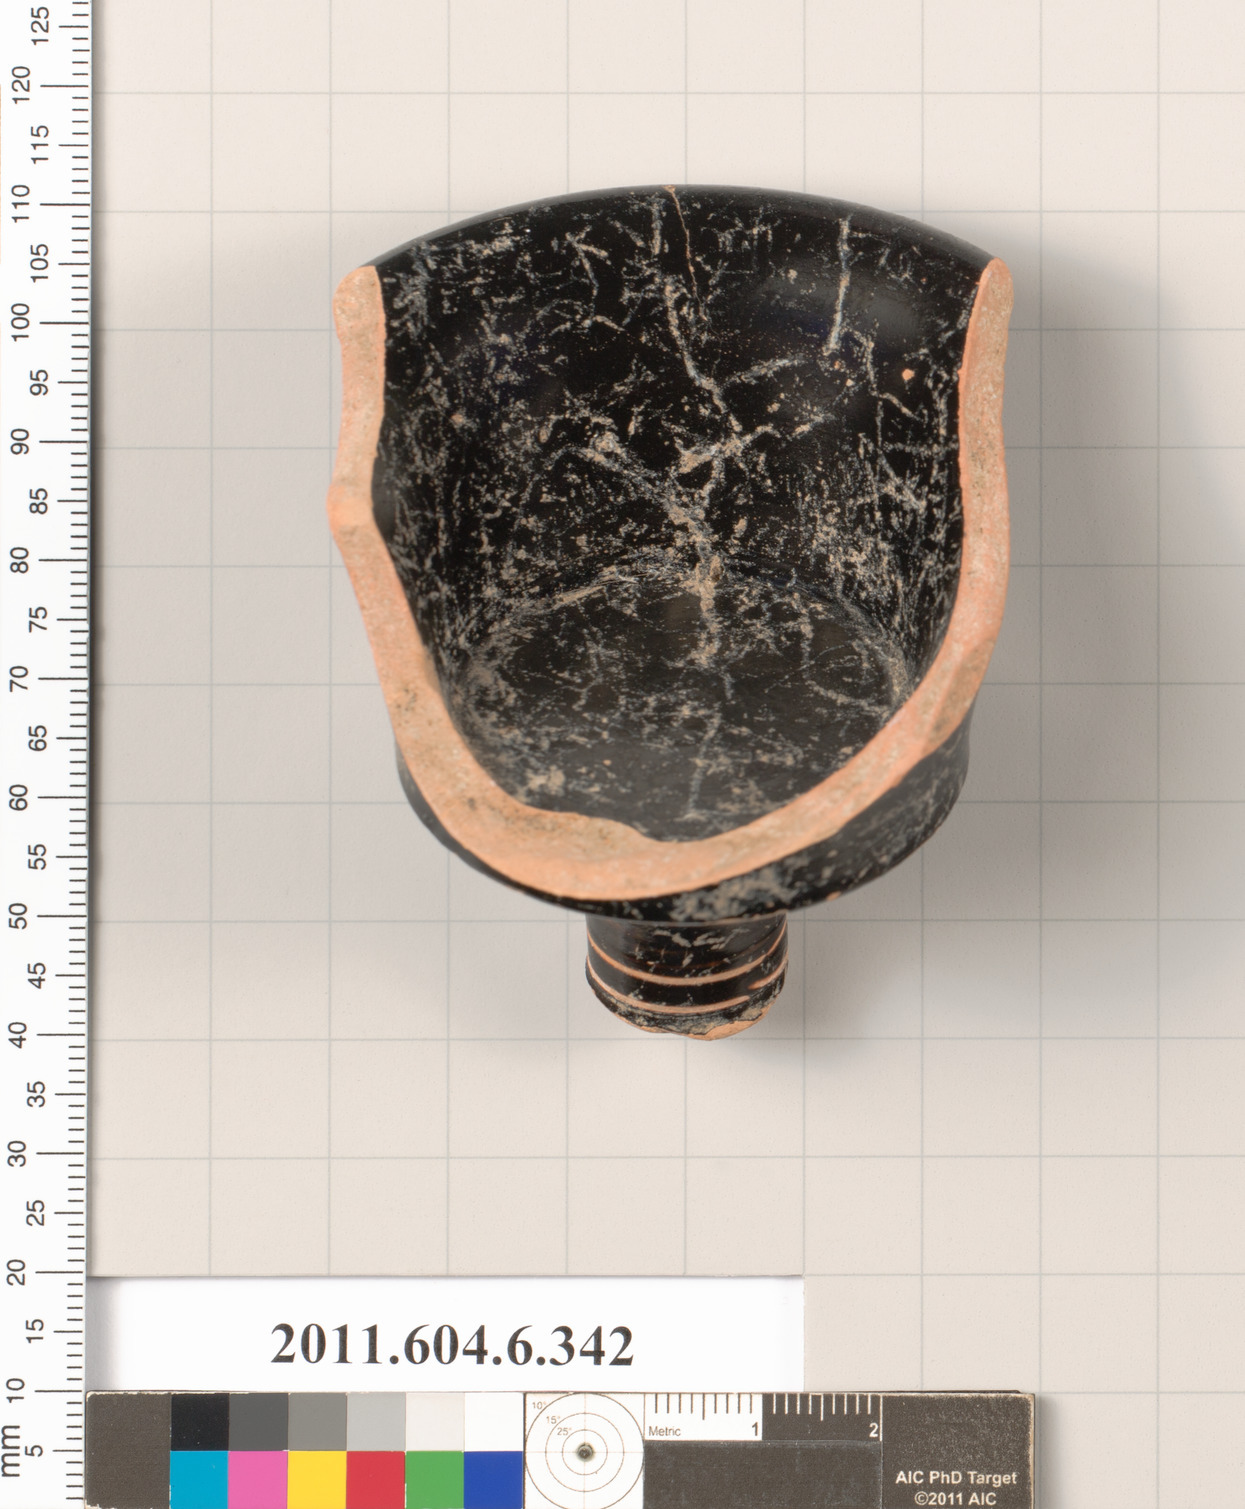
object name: kalathos fragment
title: Terracotta fragment of a kalathos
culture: greek, attic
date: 500 BCE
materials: terracotta